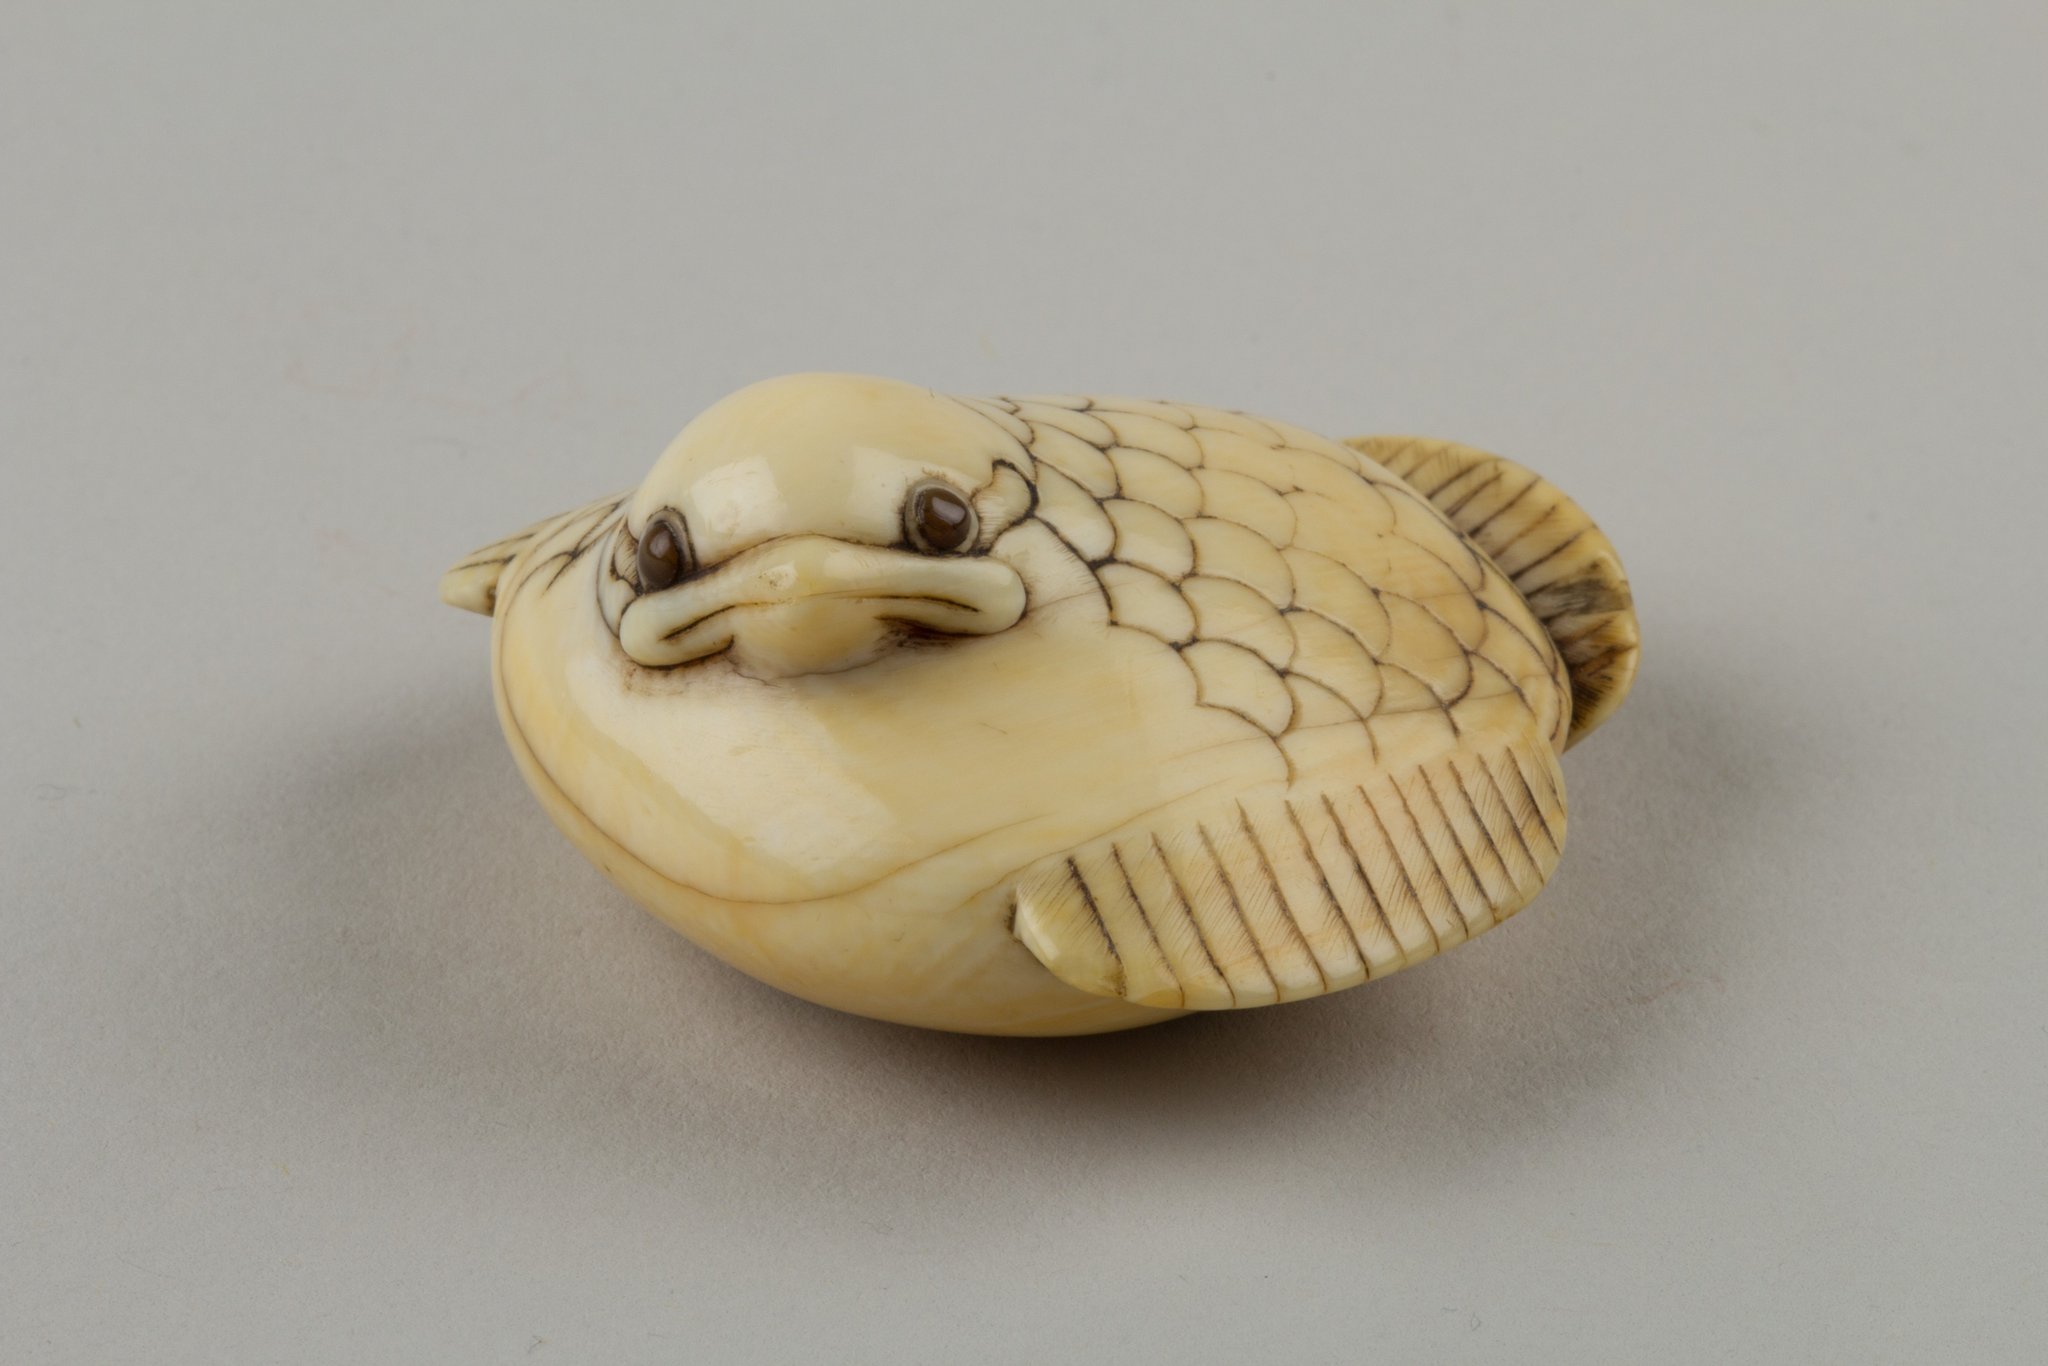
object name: netsuke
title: Netsuke of a Plum Sparrow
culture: japanese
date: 1767-1800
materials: horn, ivory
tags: birds